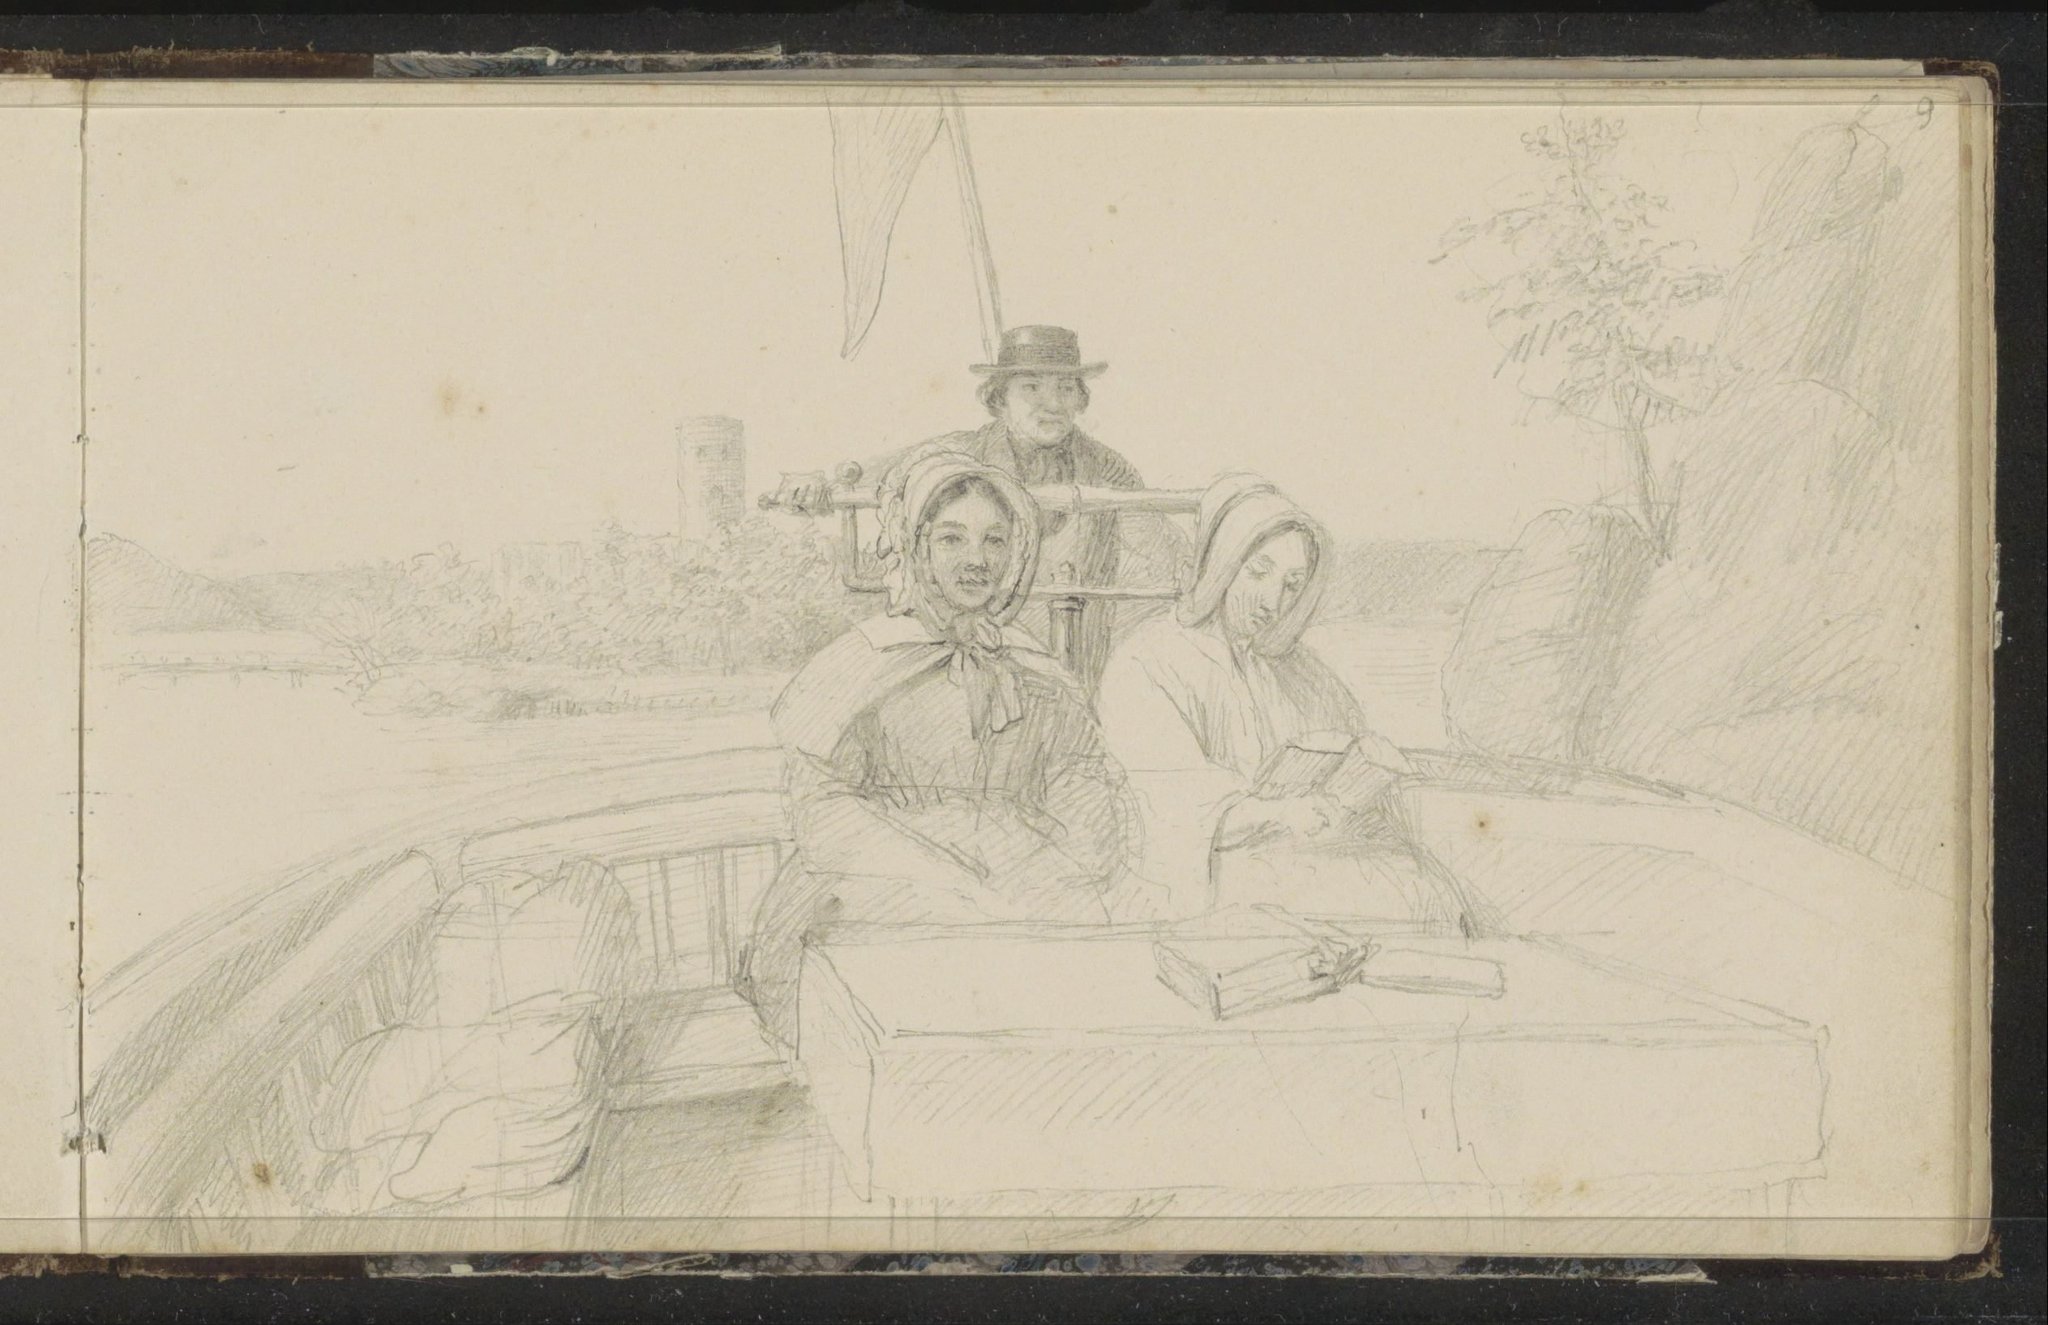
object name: sketchbook leaf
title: Twee vrouwen en een schipper op een boot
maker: christian heinrich gottlieb steuerwald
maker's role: draughtsman, print maker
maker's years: 1802-1874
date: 1845-1848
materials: paper, pencil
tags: crew and passengers ~ ship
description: Eén van de vrouwen leest een boek. De ander kijkt recht vooruit. Op de achtergrond een toren in een landschap. Blad 9 recto uit een schetsboek met 61 bladen.